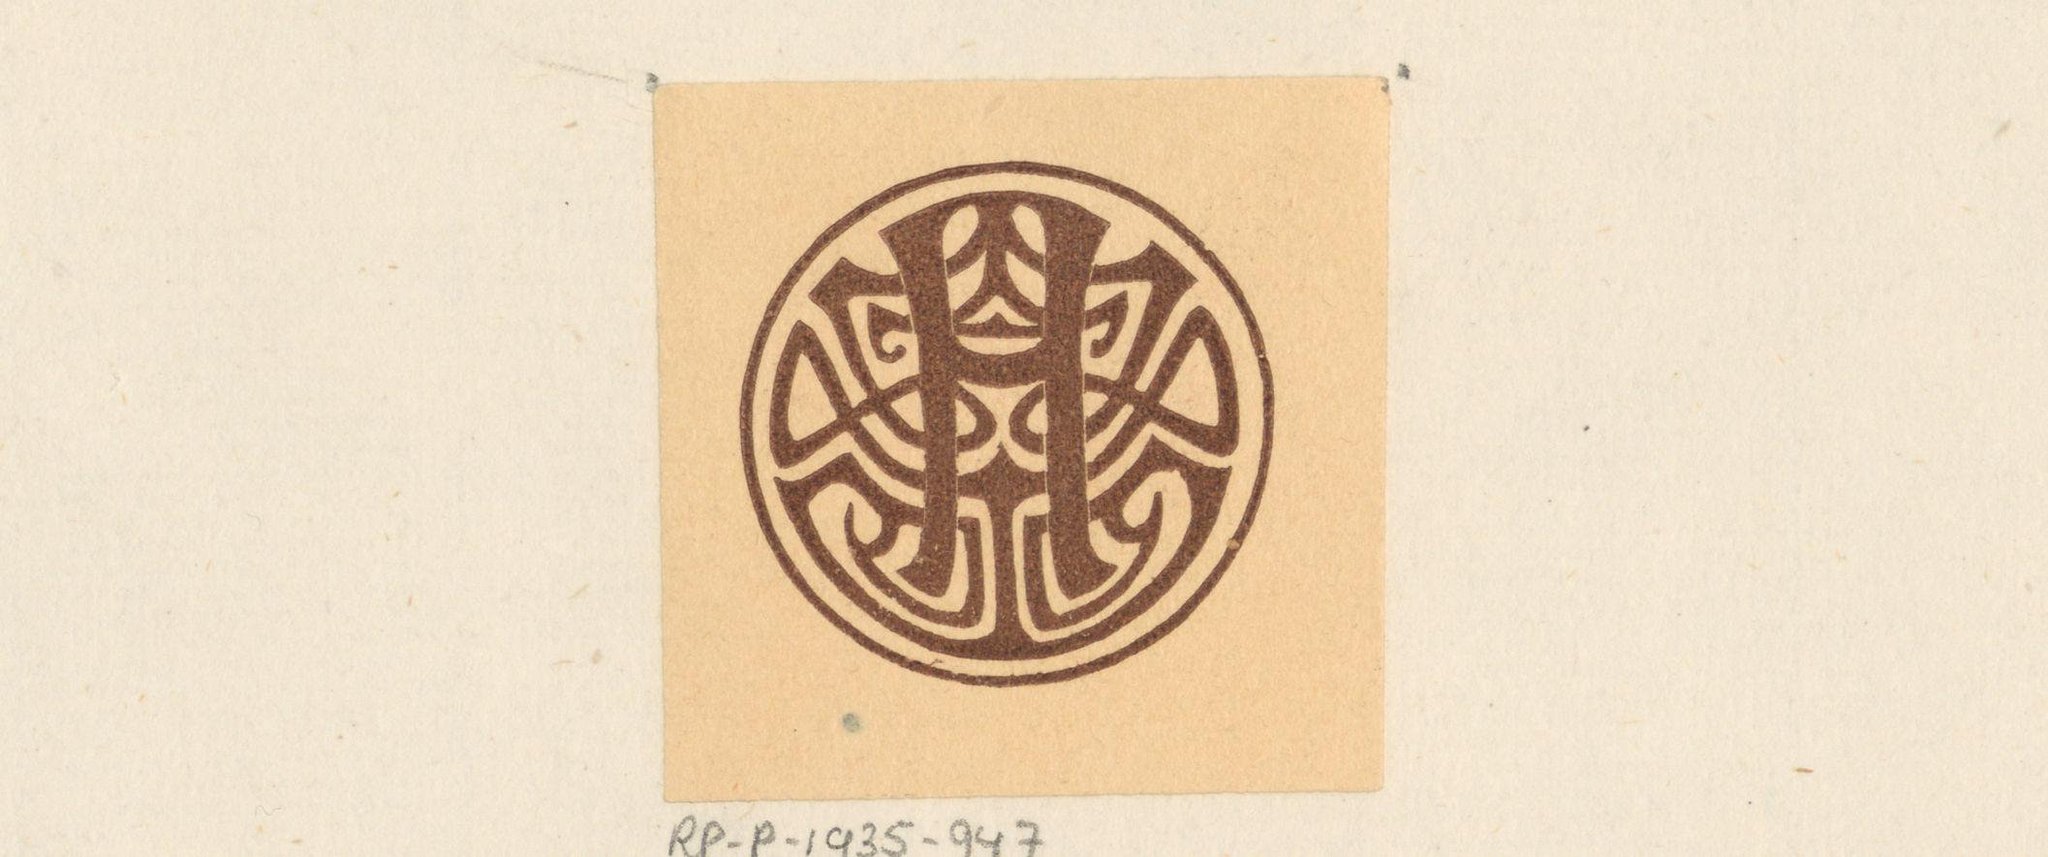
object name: bookplate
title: Ex libris van H.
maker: julie de graag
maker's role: draughtsman, print maker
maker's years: 1877-1924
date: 1887-1924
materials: paper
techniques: woodcut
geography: netherlands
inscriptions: collector's mark: Lugt 2228